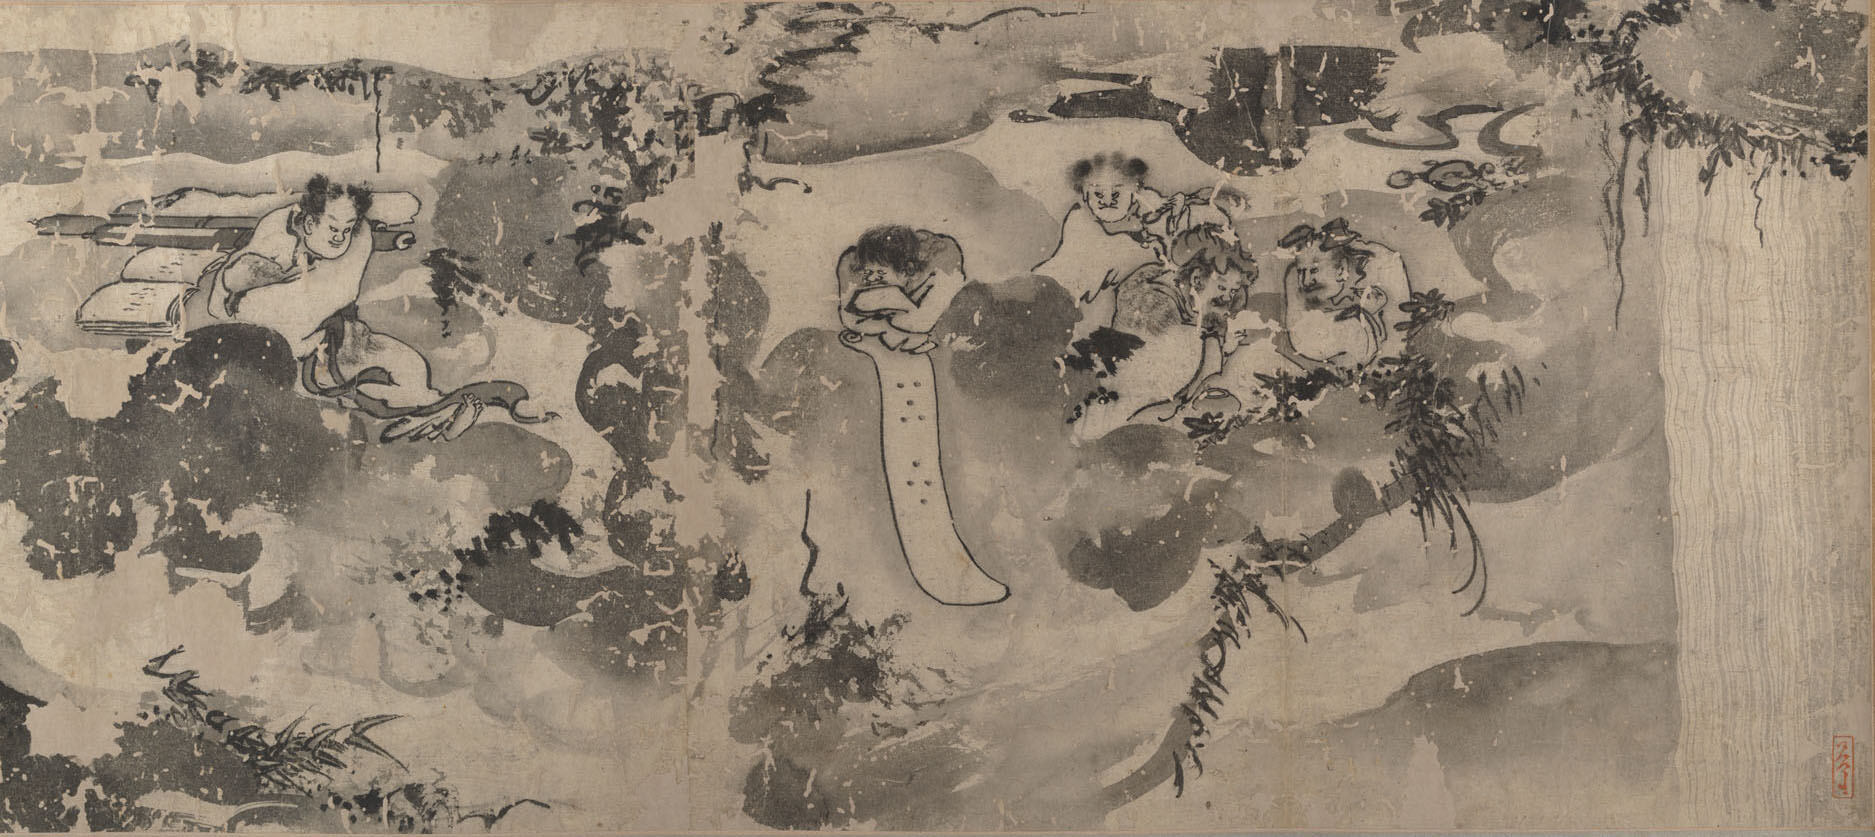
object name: handscroll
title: Merry Gatherings in the Magic Jar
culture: chinese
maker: unidentified artist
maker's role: artist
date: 1368-1911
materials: ink, paper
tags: men,landscapes